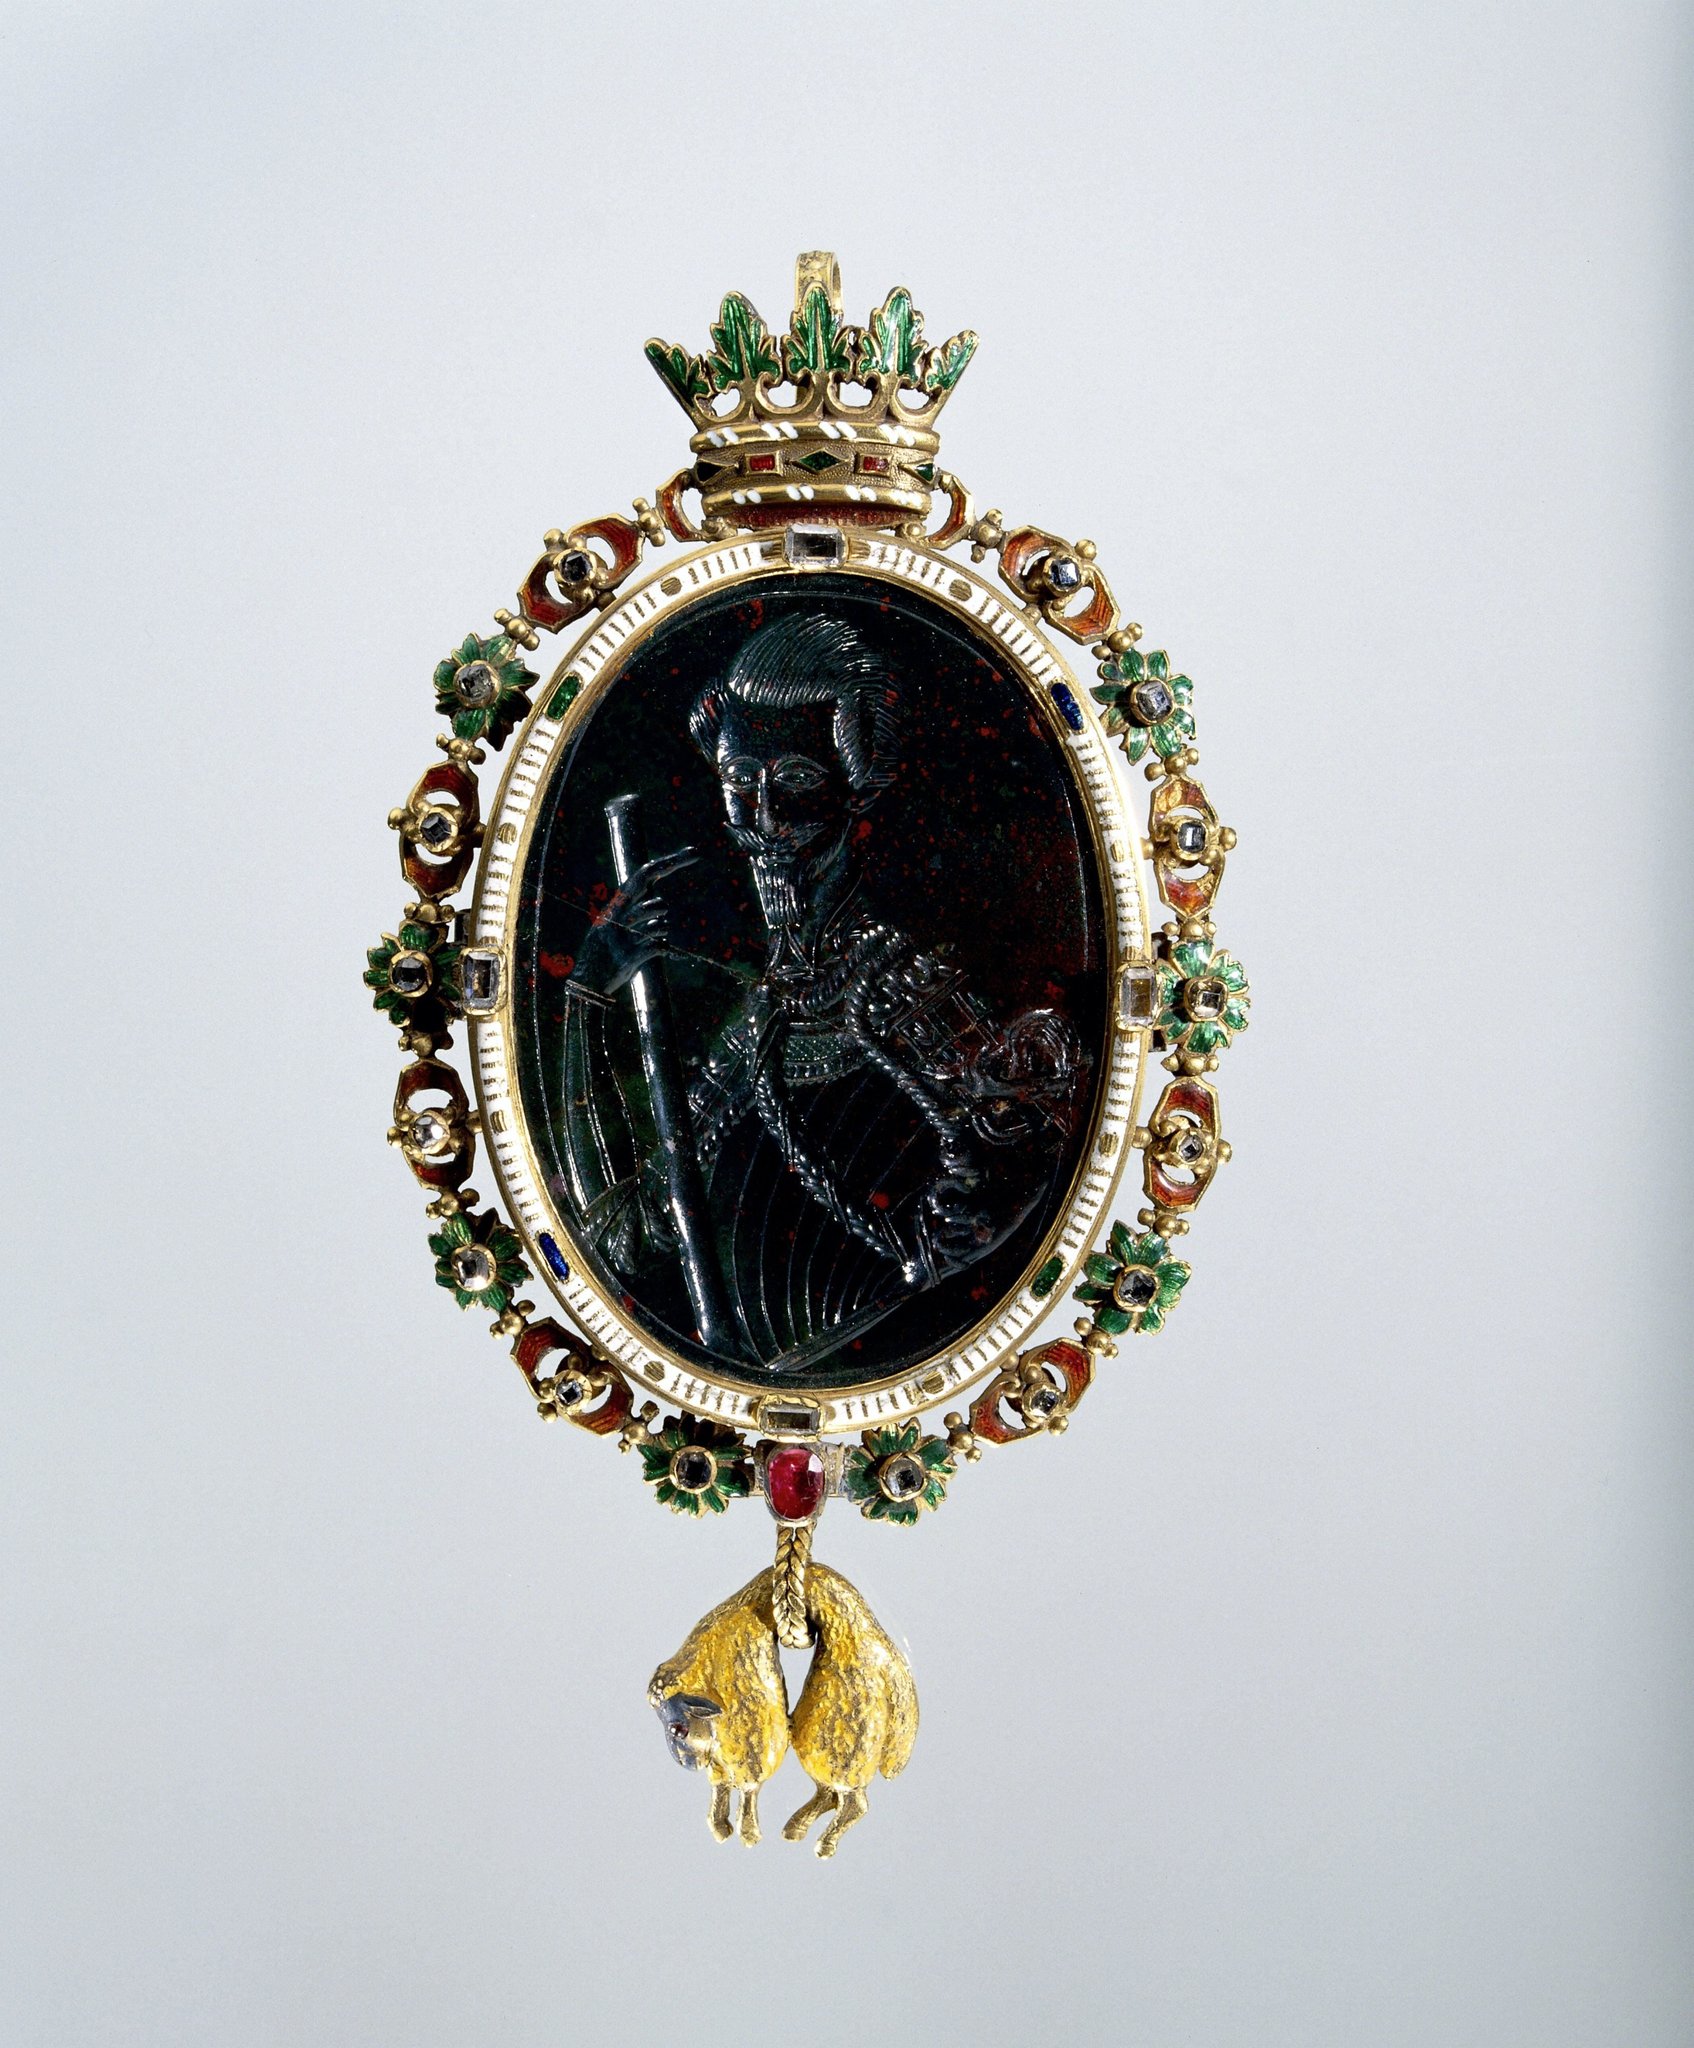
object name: locket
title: Medaillon met een ridder van het Gulden vlies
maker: Anonymous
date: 1600-1620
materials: diamond, glass, gold, gemstone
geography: germany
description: Medallion, knight of the Golden Fleece. Gold, diamonds, bloodstone jasper and enamel. Germany, c. 1600-1620.